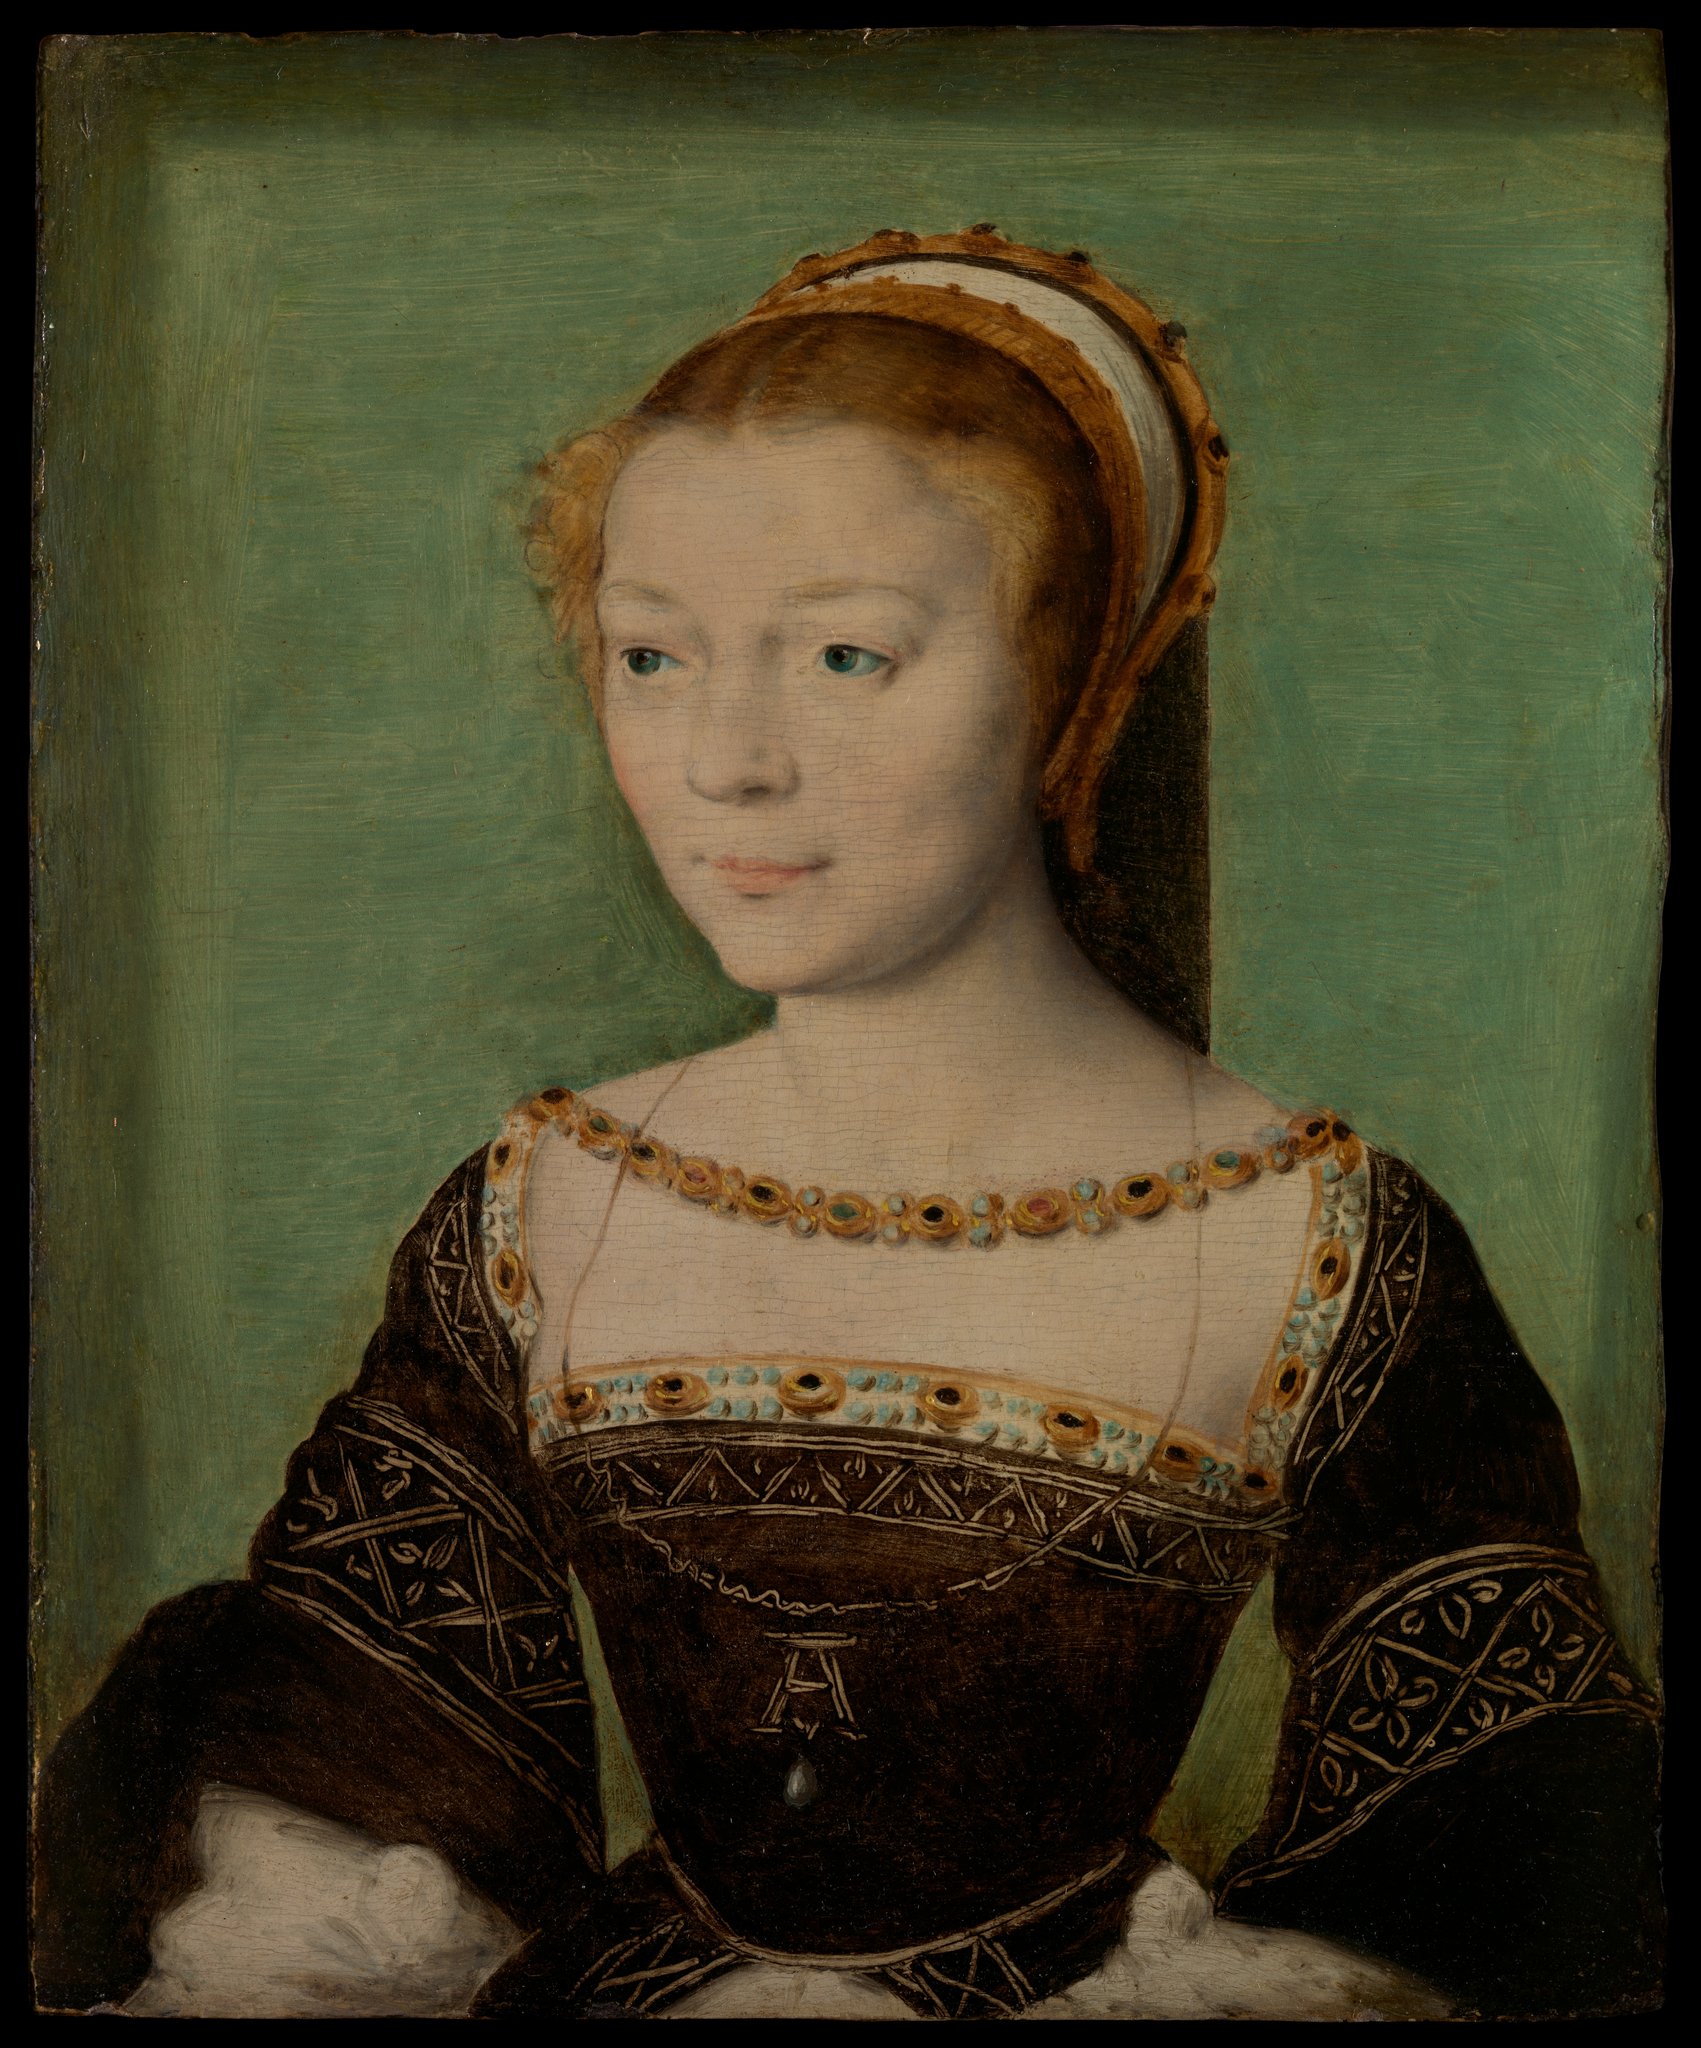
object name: painting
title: Anne de Pisseleu (1508–1576), Duchesse d'Étampes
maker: corneille de lyon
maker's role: artist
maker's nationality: netherlandish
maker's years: 1533-1575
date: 1535-1540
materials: oil, wood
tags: portraits,women